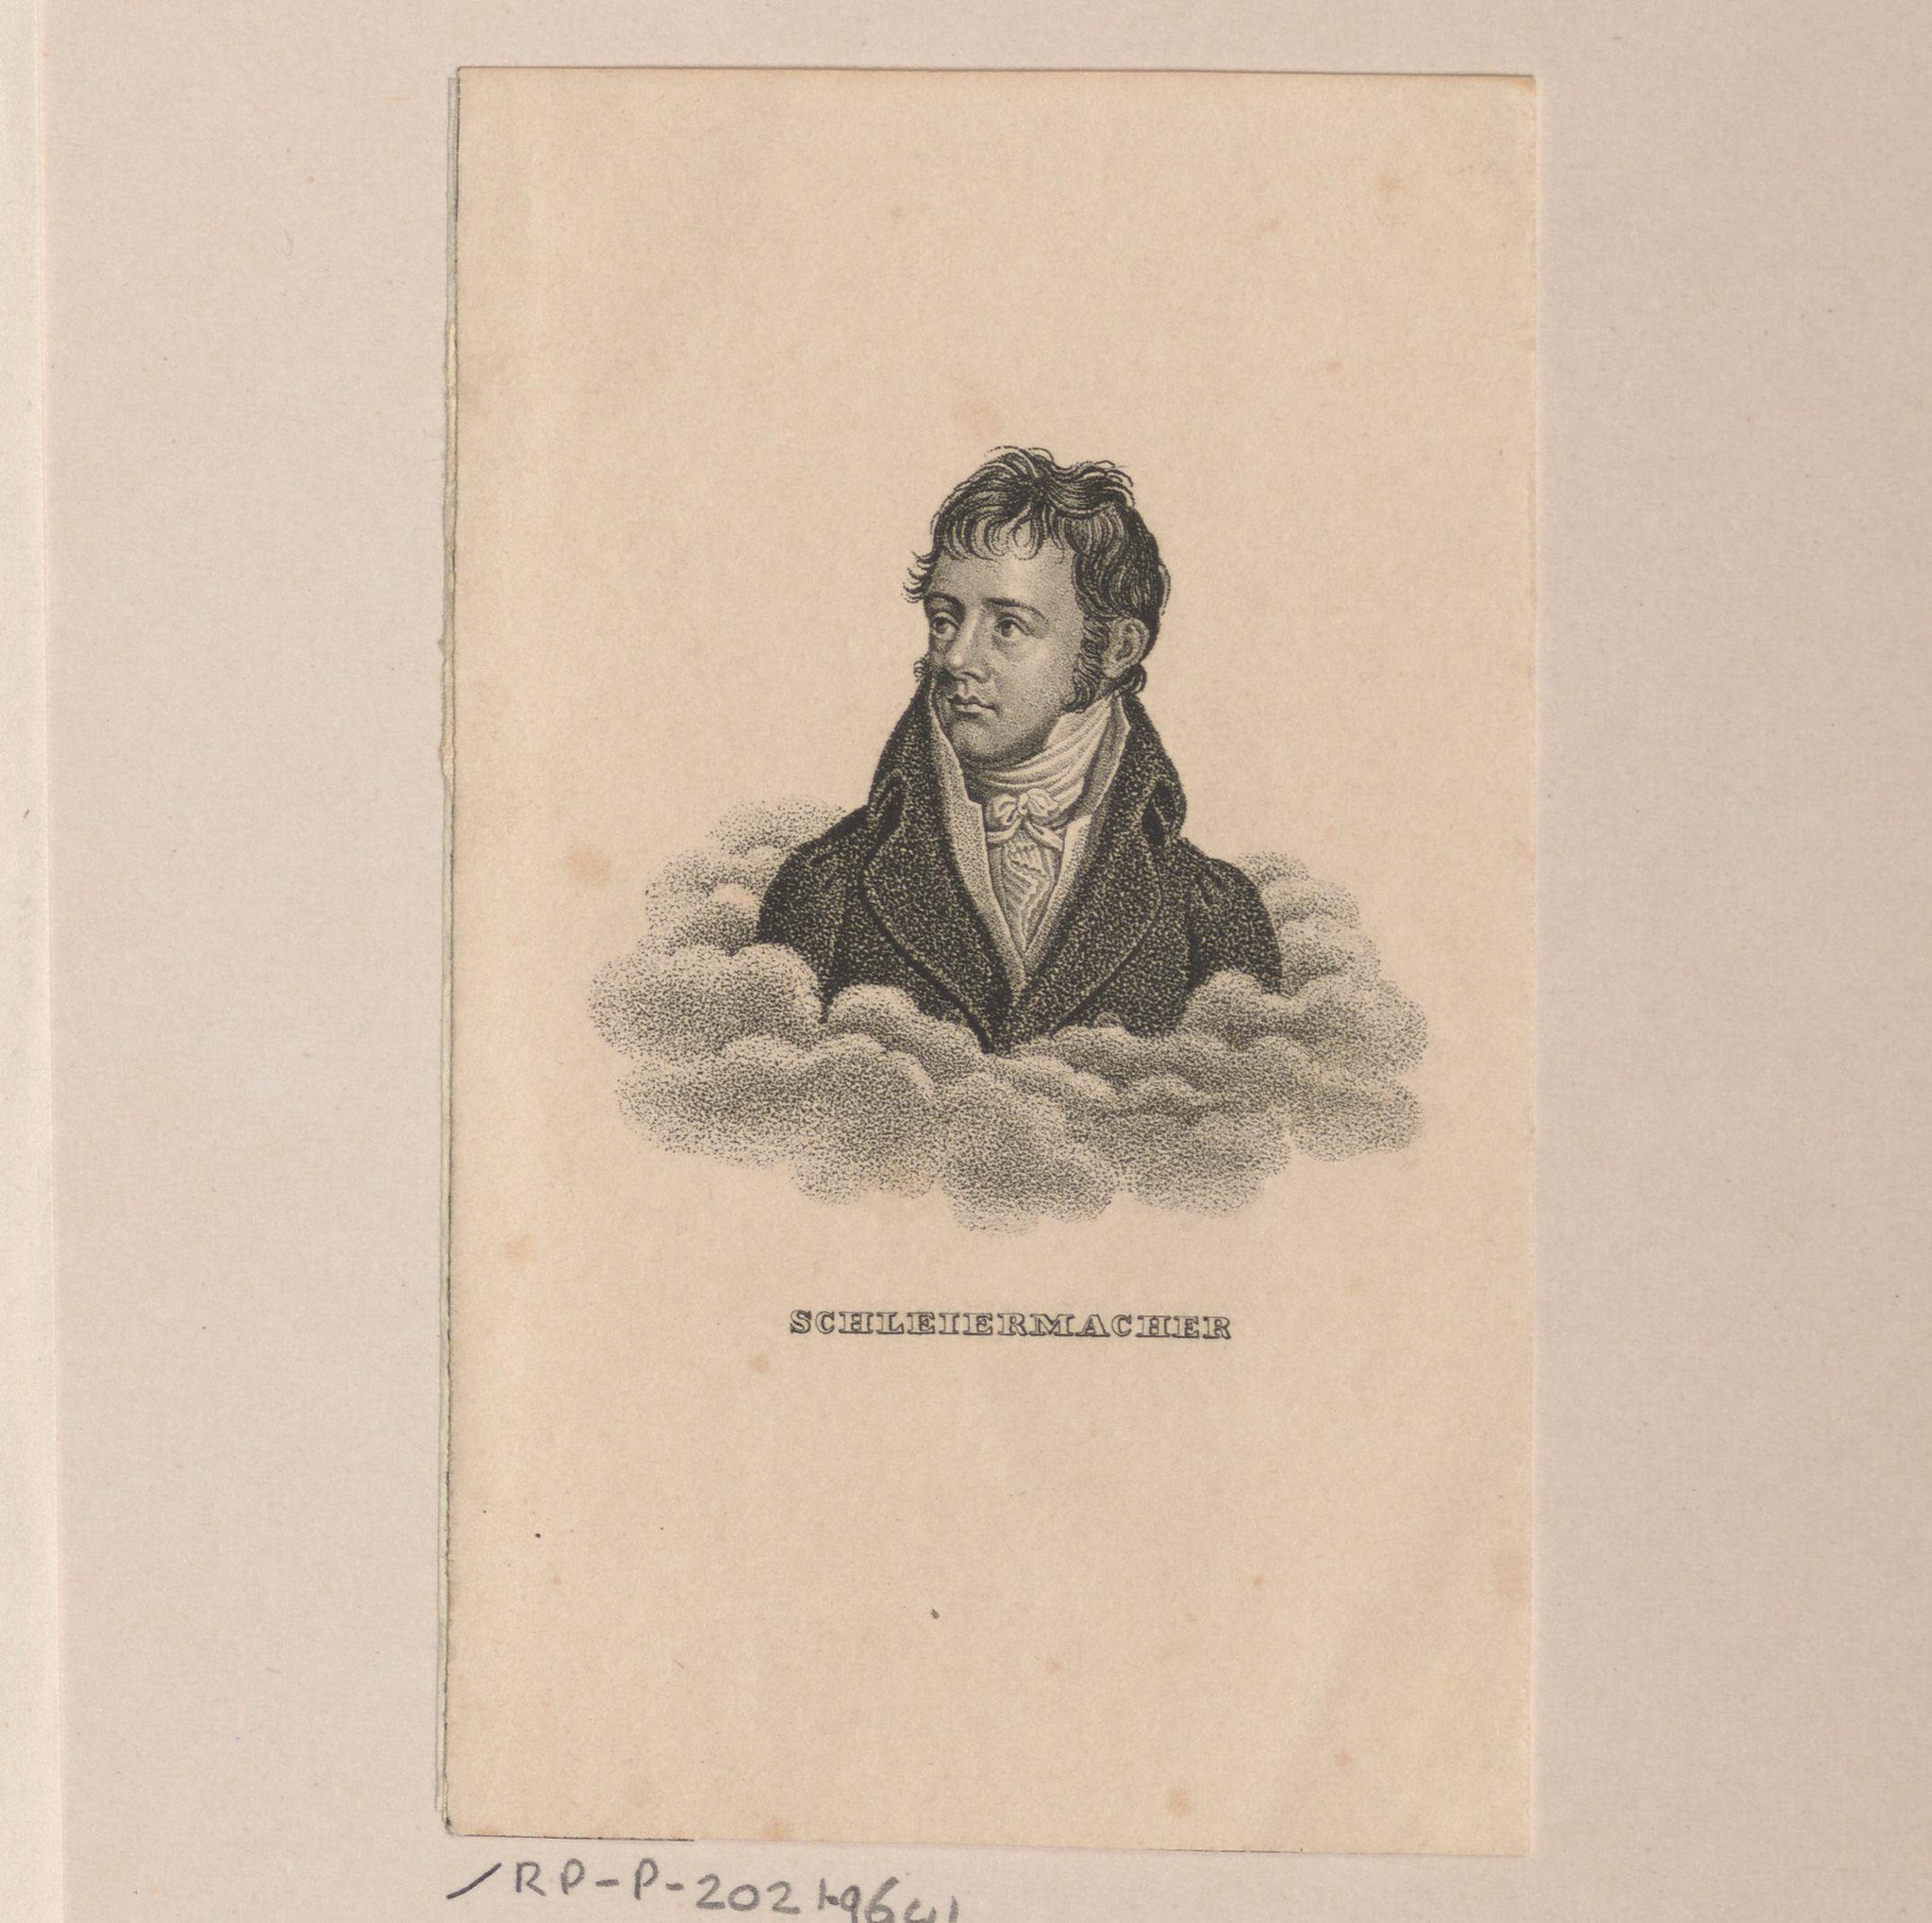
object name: print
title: Portret van Friedrich Ernst Daniel Schleiermacher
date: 1800-1830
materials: paper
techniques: etching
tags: theologian, historical persons